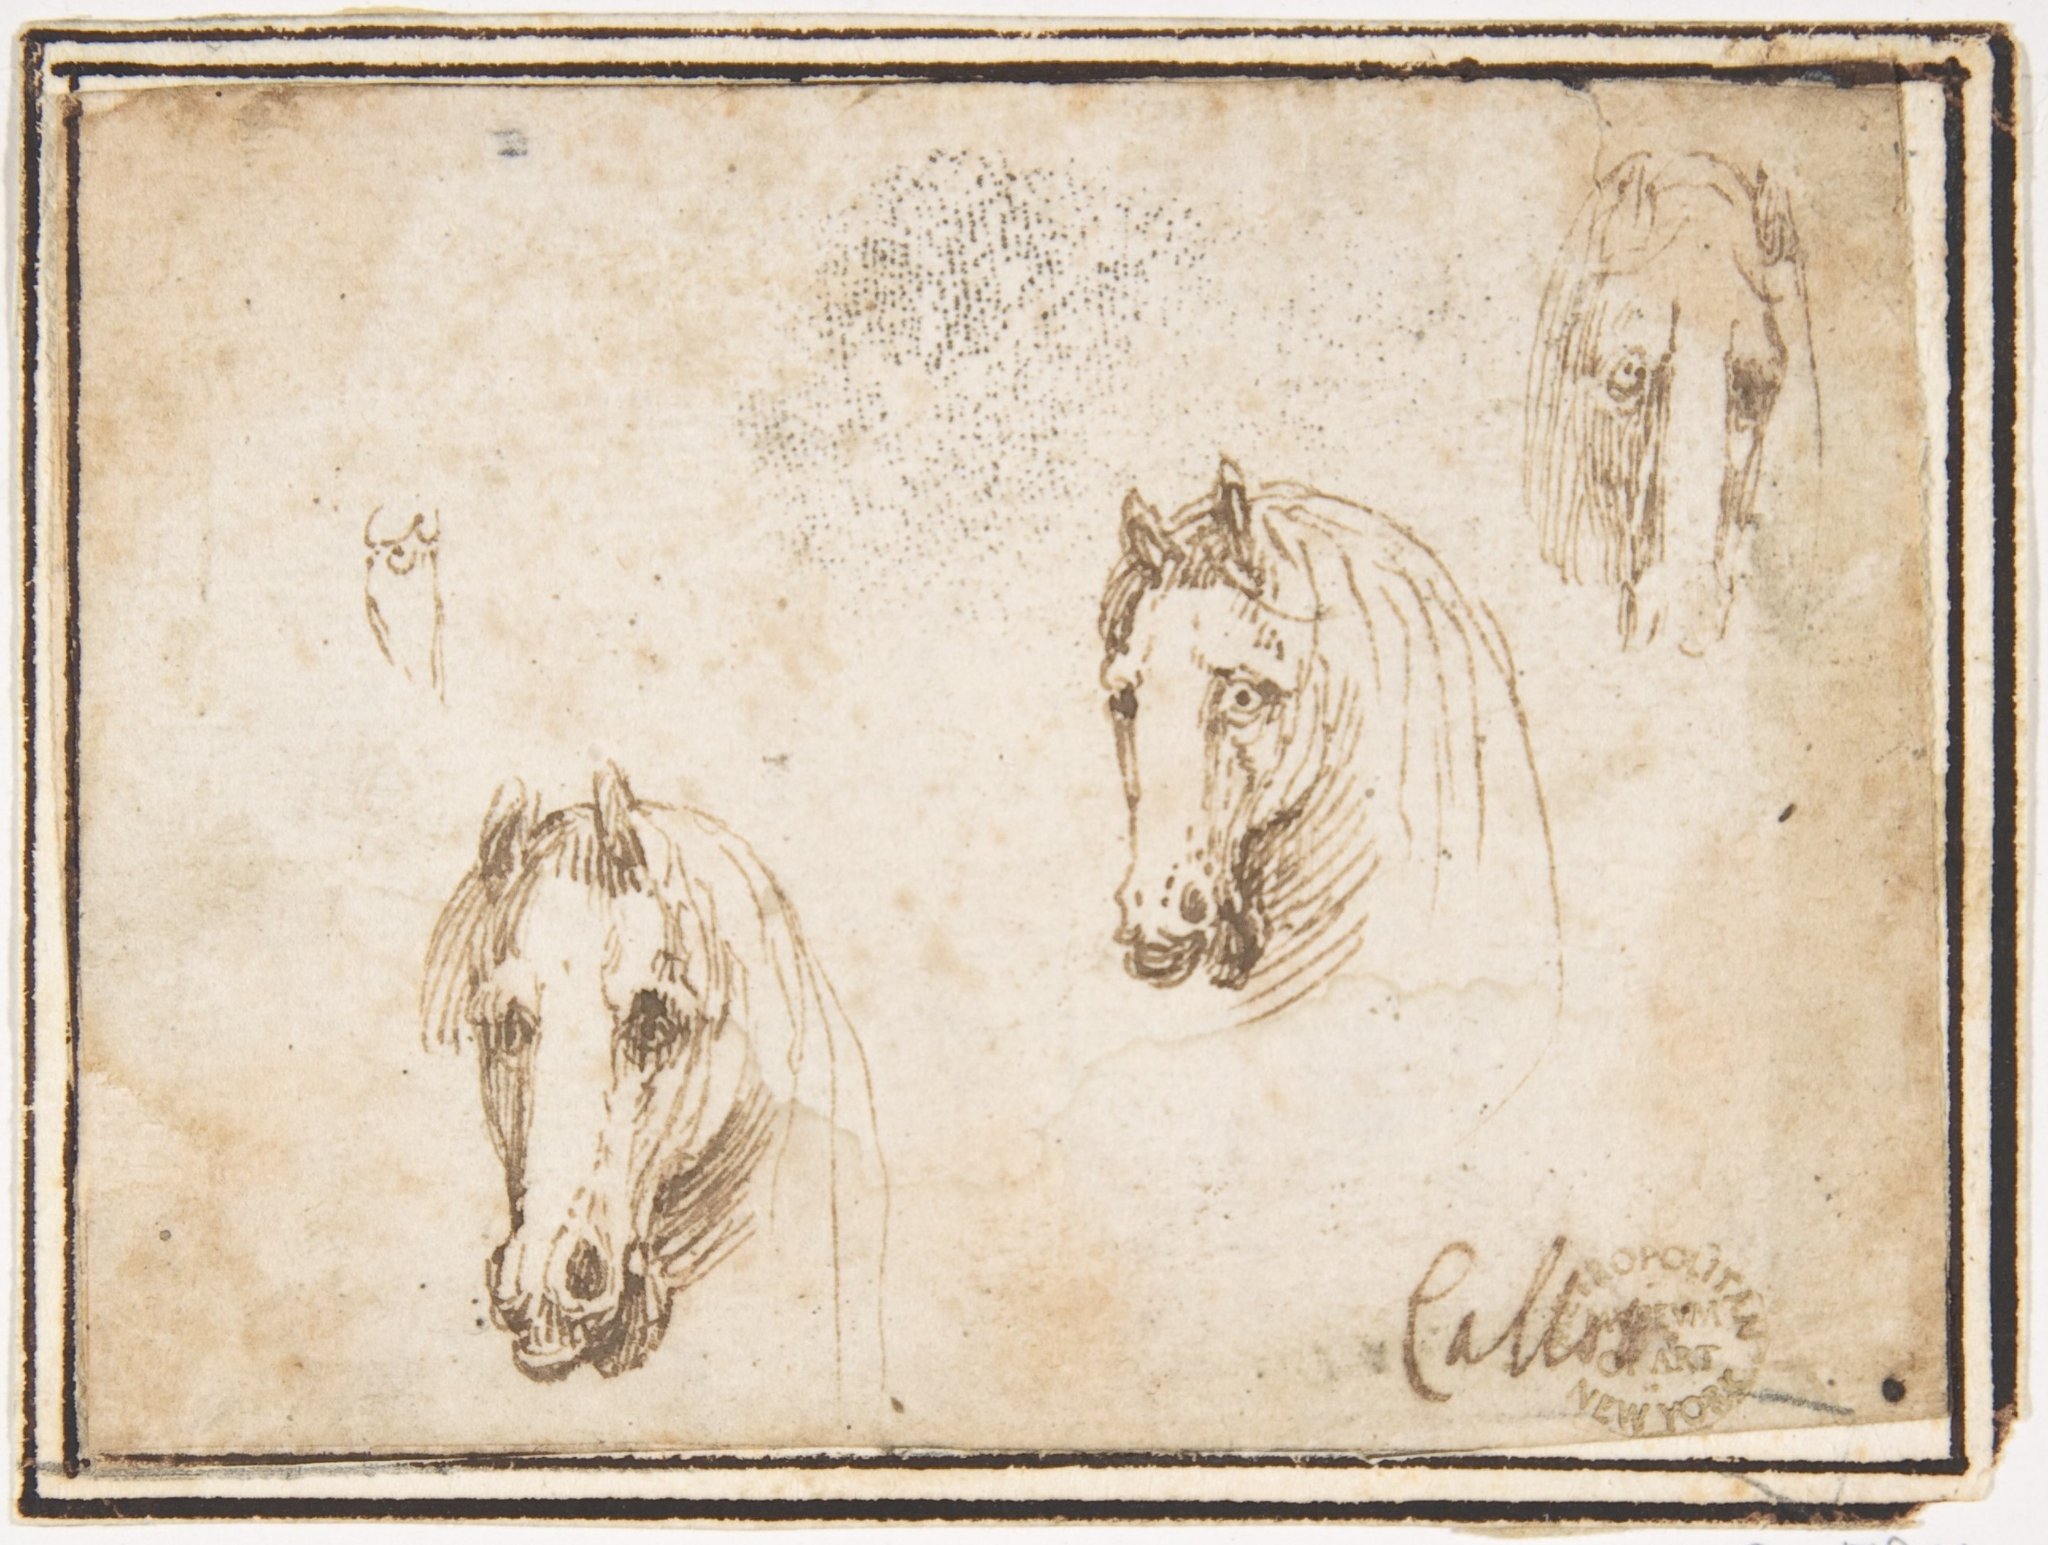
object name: drawing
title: Horses' Heads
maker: francesco allegrini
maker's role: artist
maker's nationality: italian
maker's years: 1615-1679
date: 1624-1663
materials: ink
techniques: pen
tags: horses